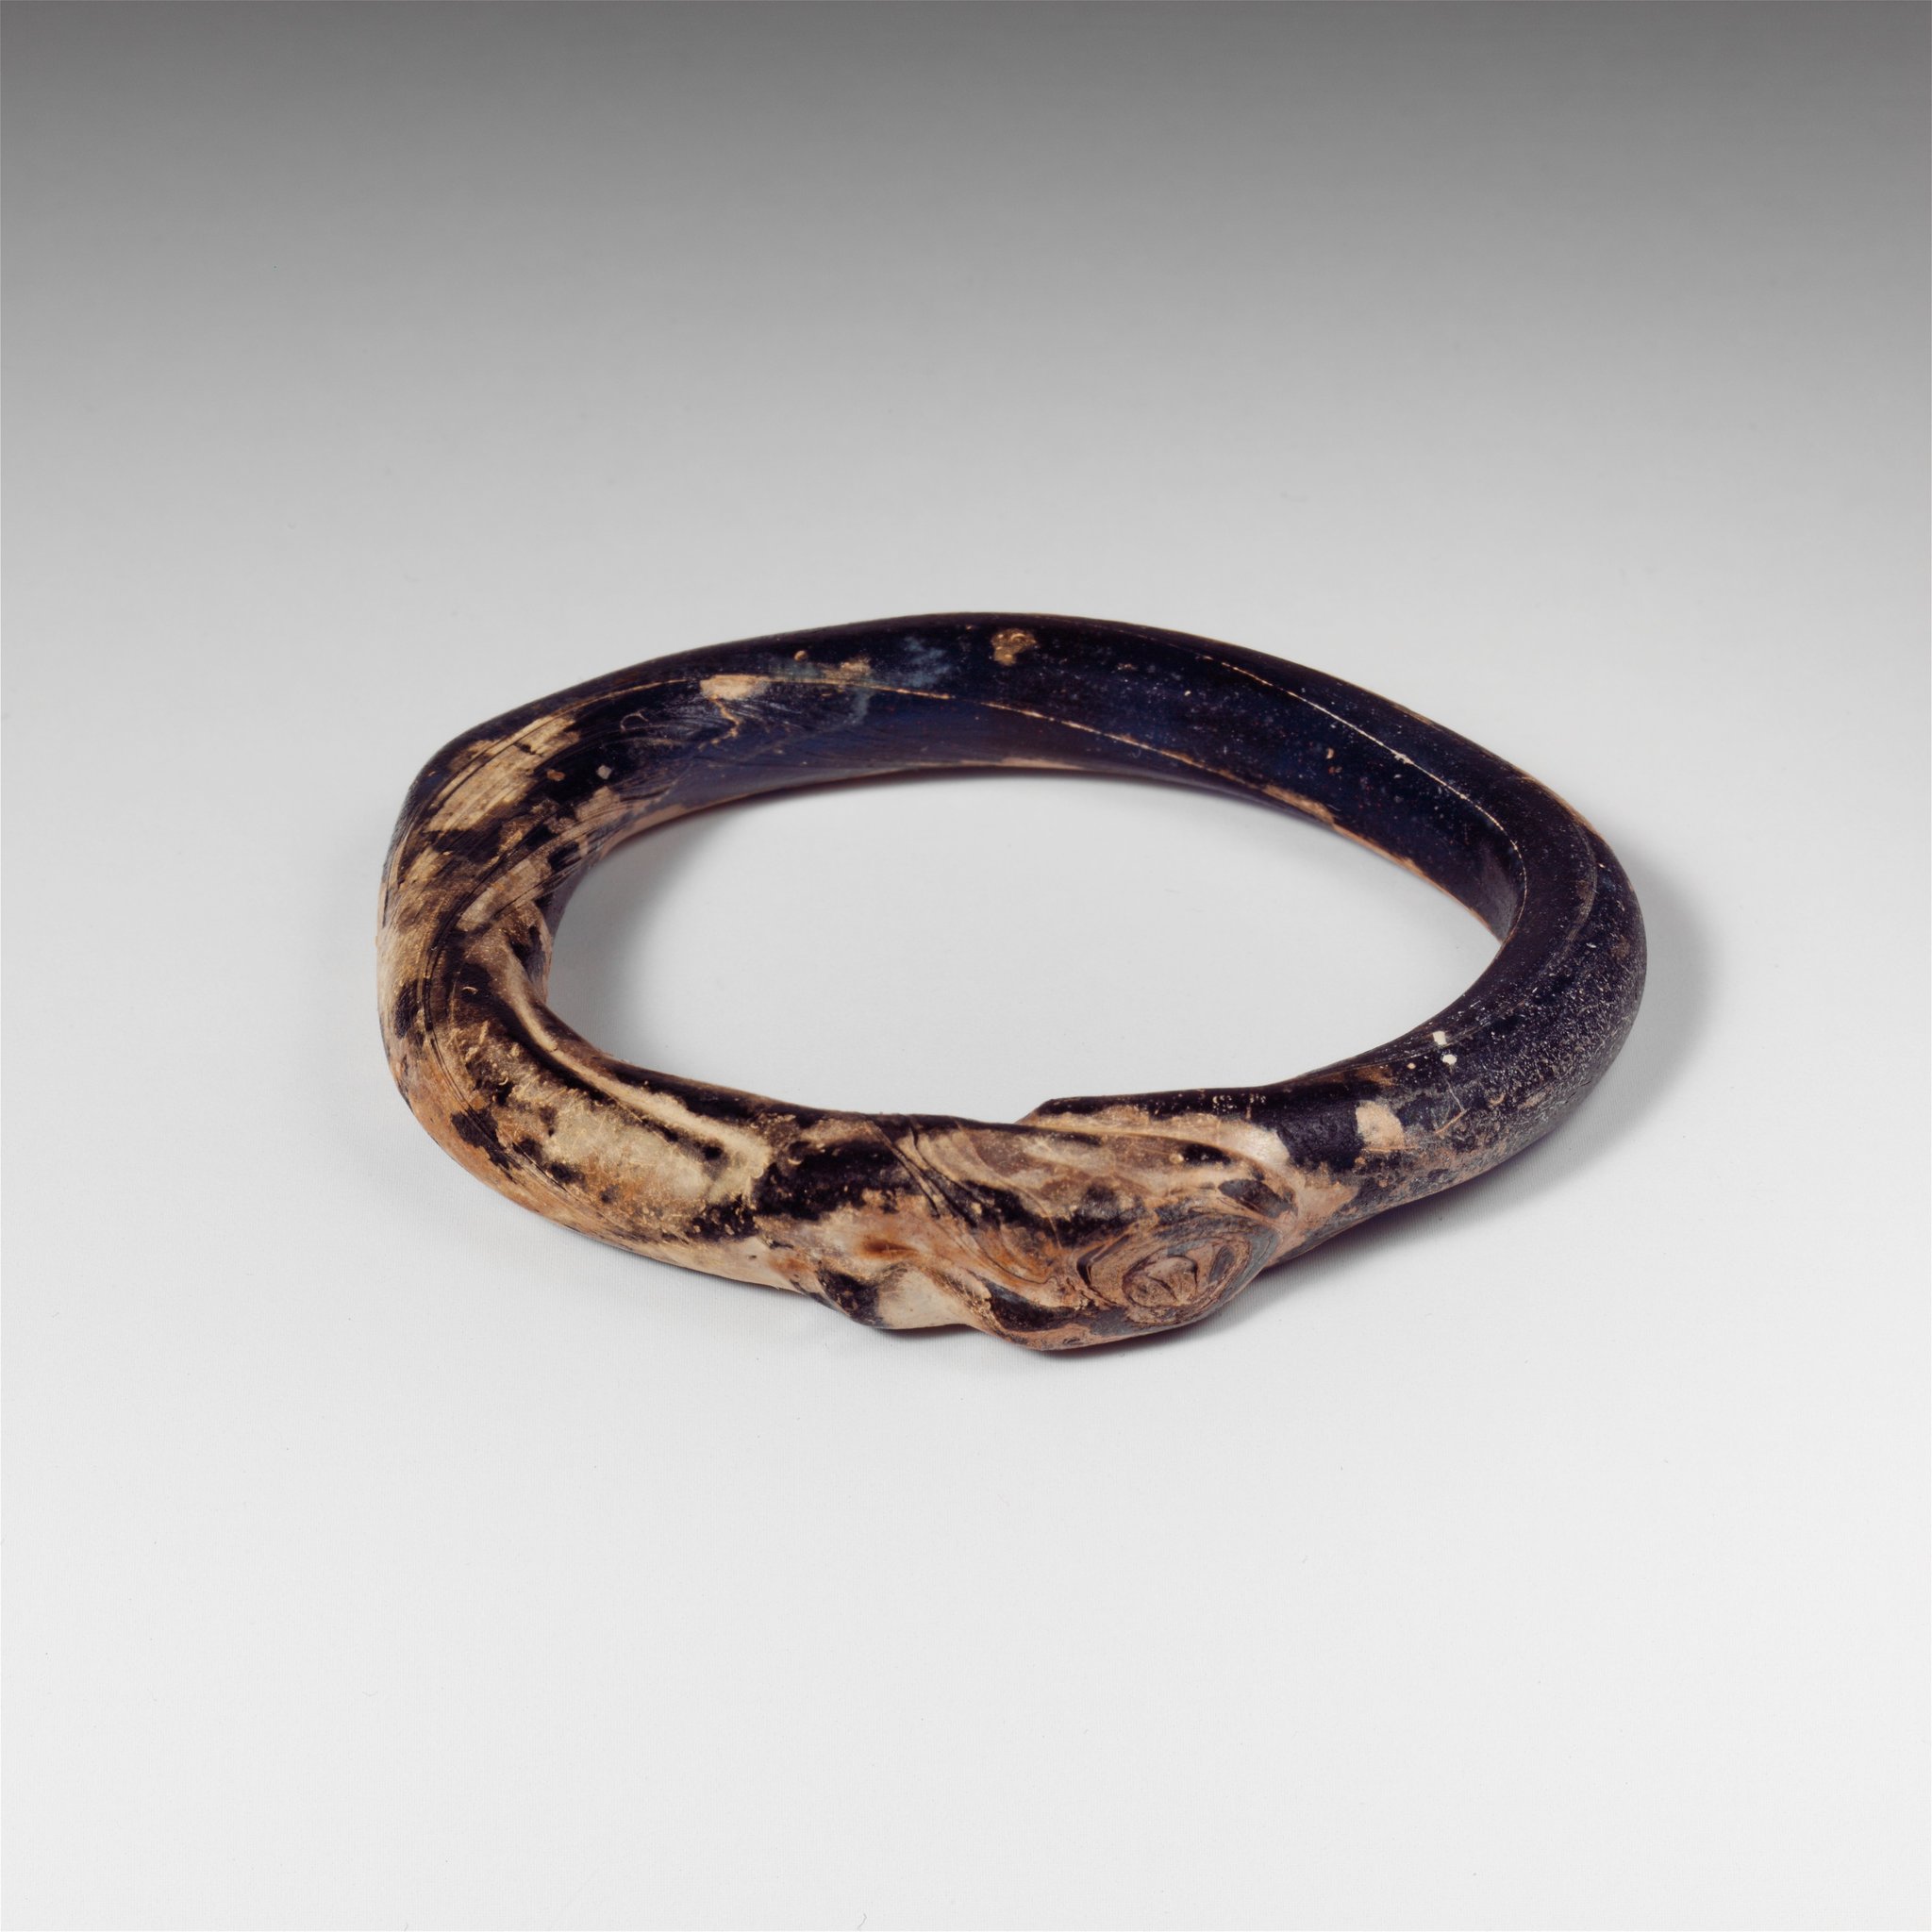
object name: bracelet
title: Glass bracelet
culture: roman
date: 101-400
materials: glass